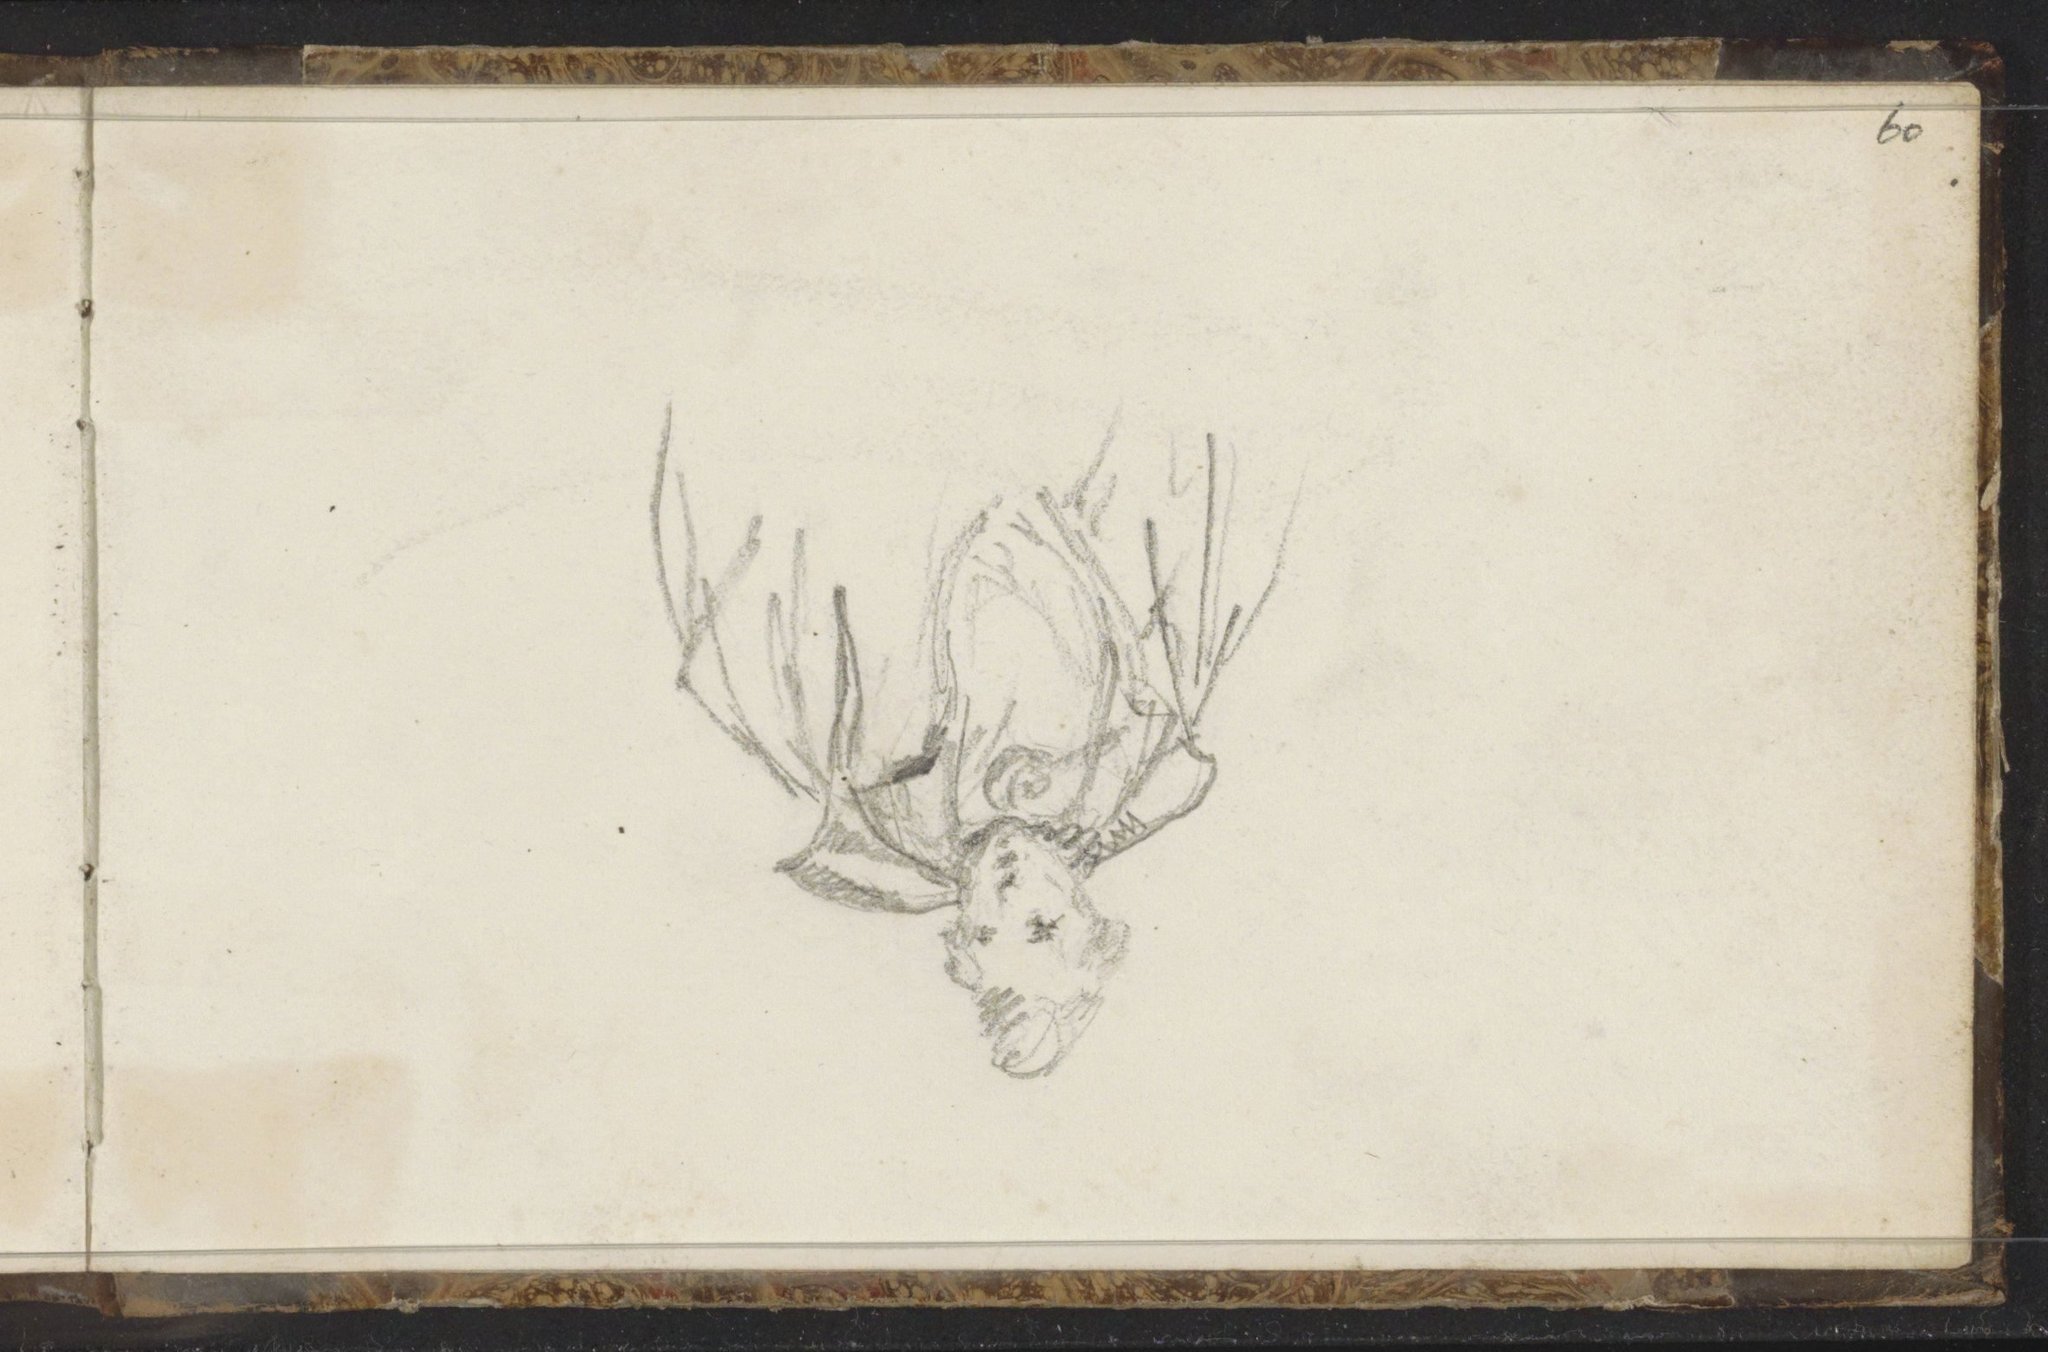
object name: sketchbook leaf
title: Portret van een man in een jas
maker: willem hendrik schmidt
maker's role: draughtsman, painter, print maker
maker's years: 1809-1849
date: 1819-1849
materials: paper, pencil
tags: anonymous historical person portrayed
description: Blad 60 recto uit een schetsboek met 60 bladen.